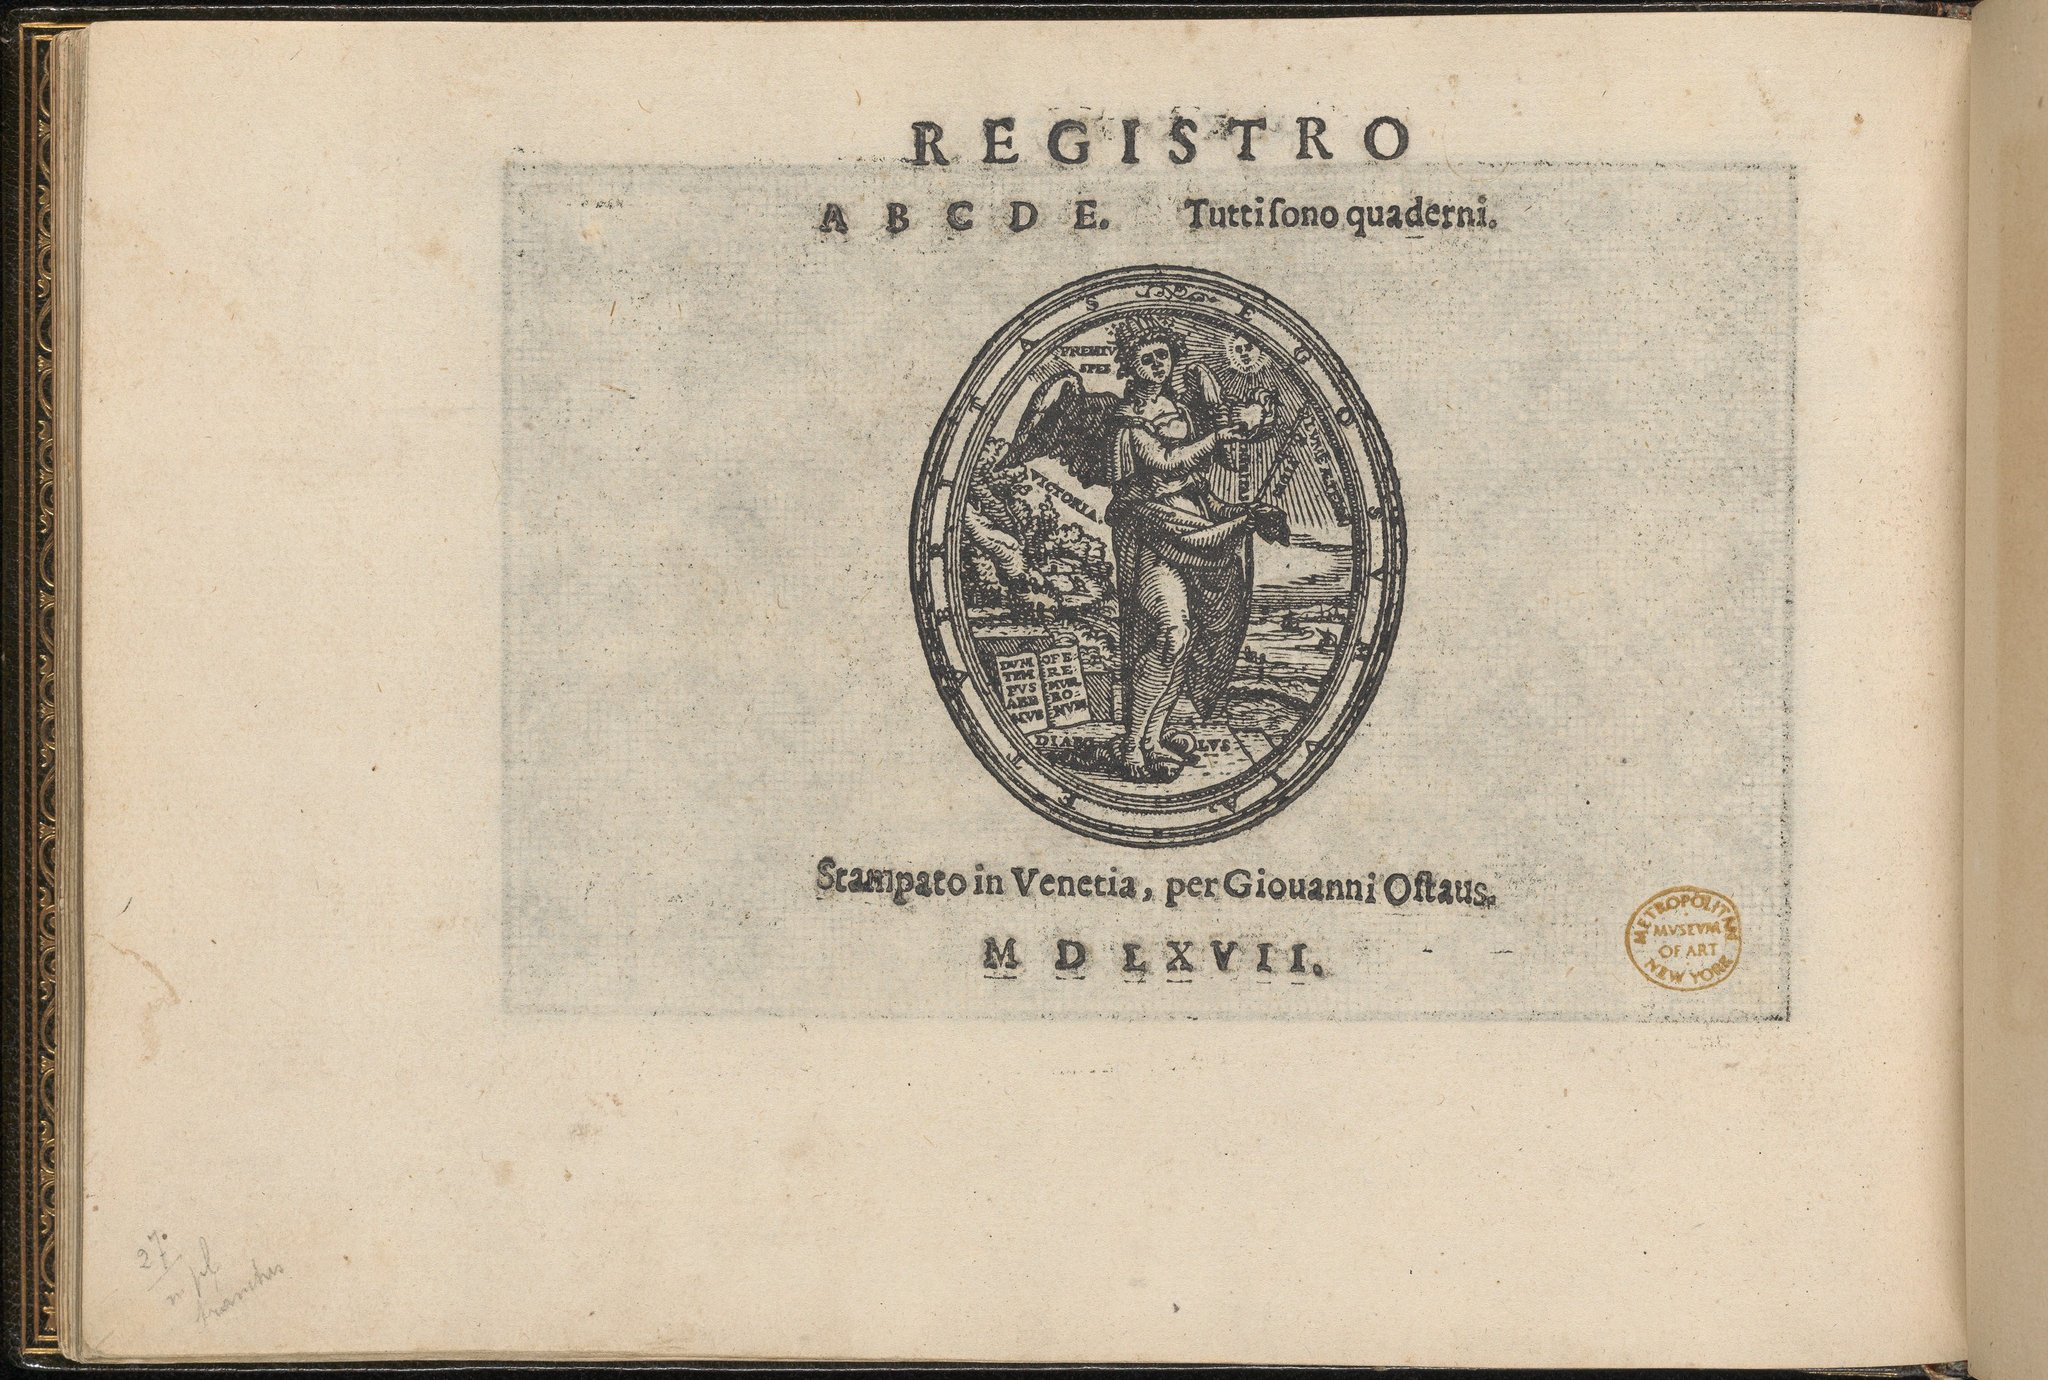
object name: book print ornament architecture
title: La Vera Perfettione del Disegno di varie sorti di recami, page 40 (verso)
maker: giovanni ostaus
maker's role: publisher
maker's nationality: italian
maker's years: 1507-1607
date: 1567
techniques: woodcut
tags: angels